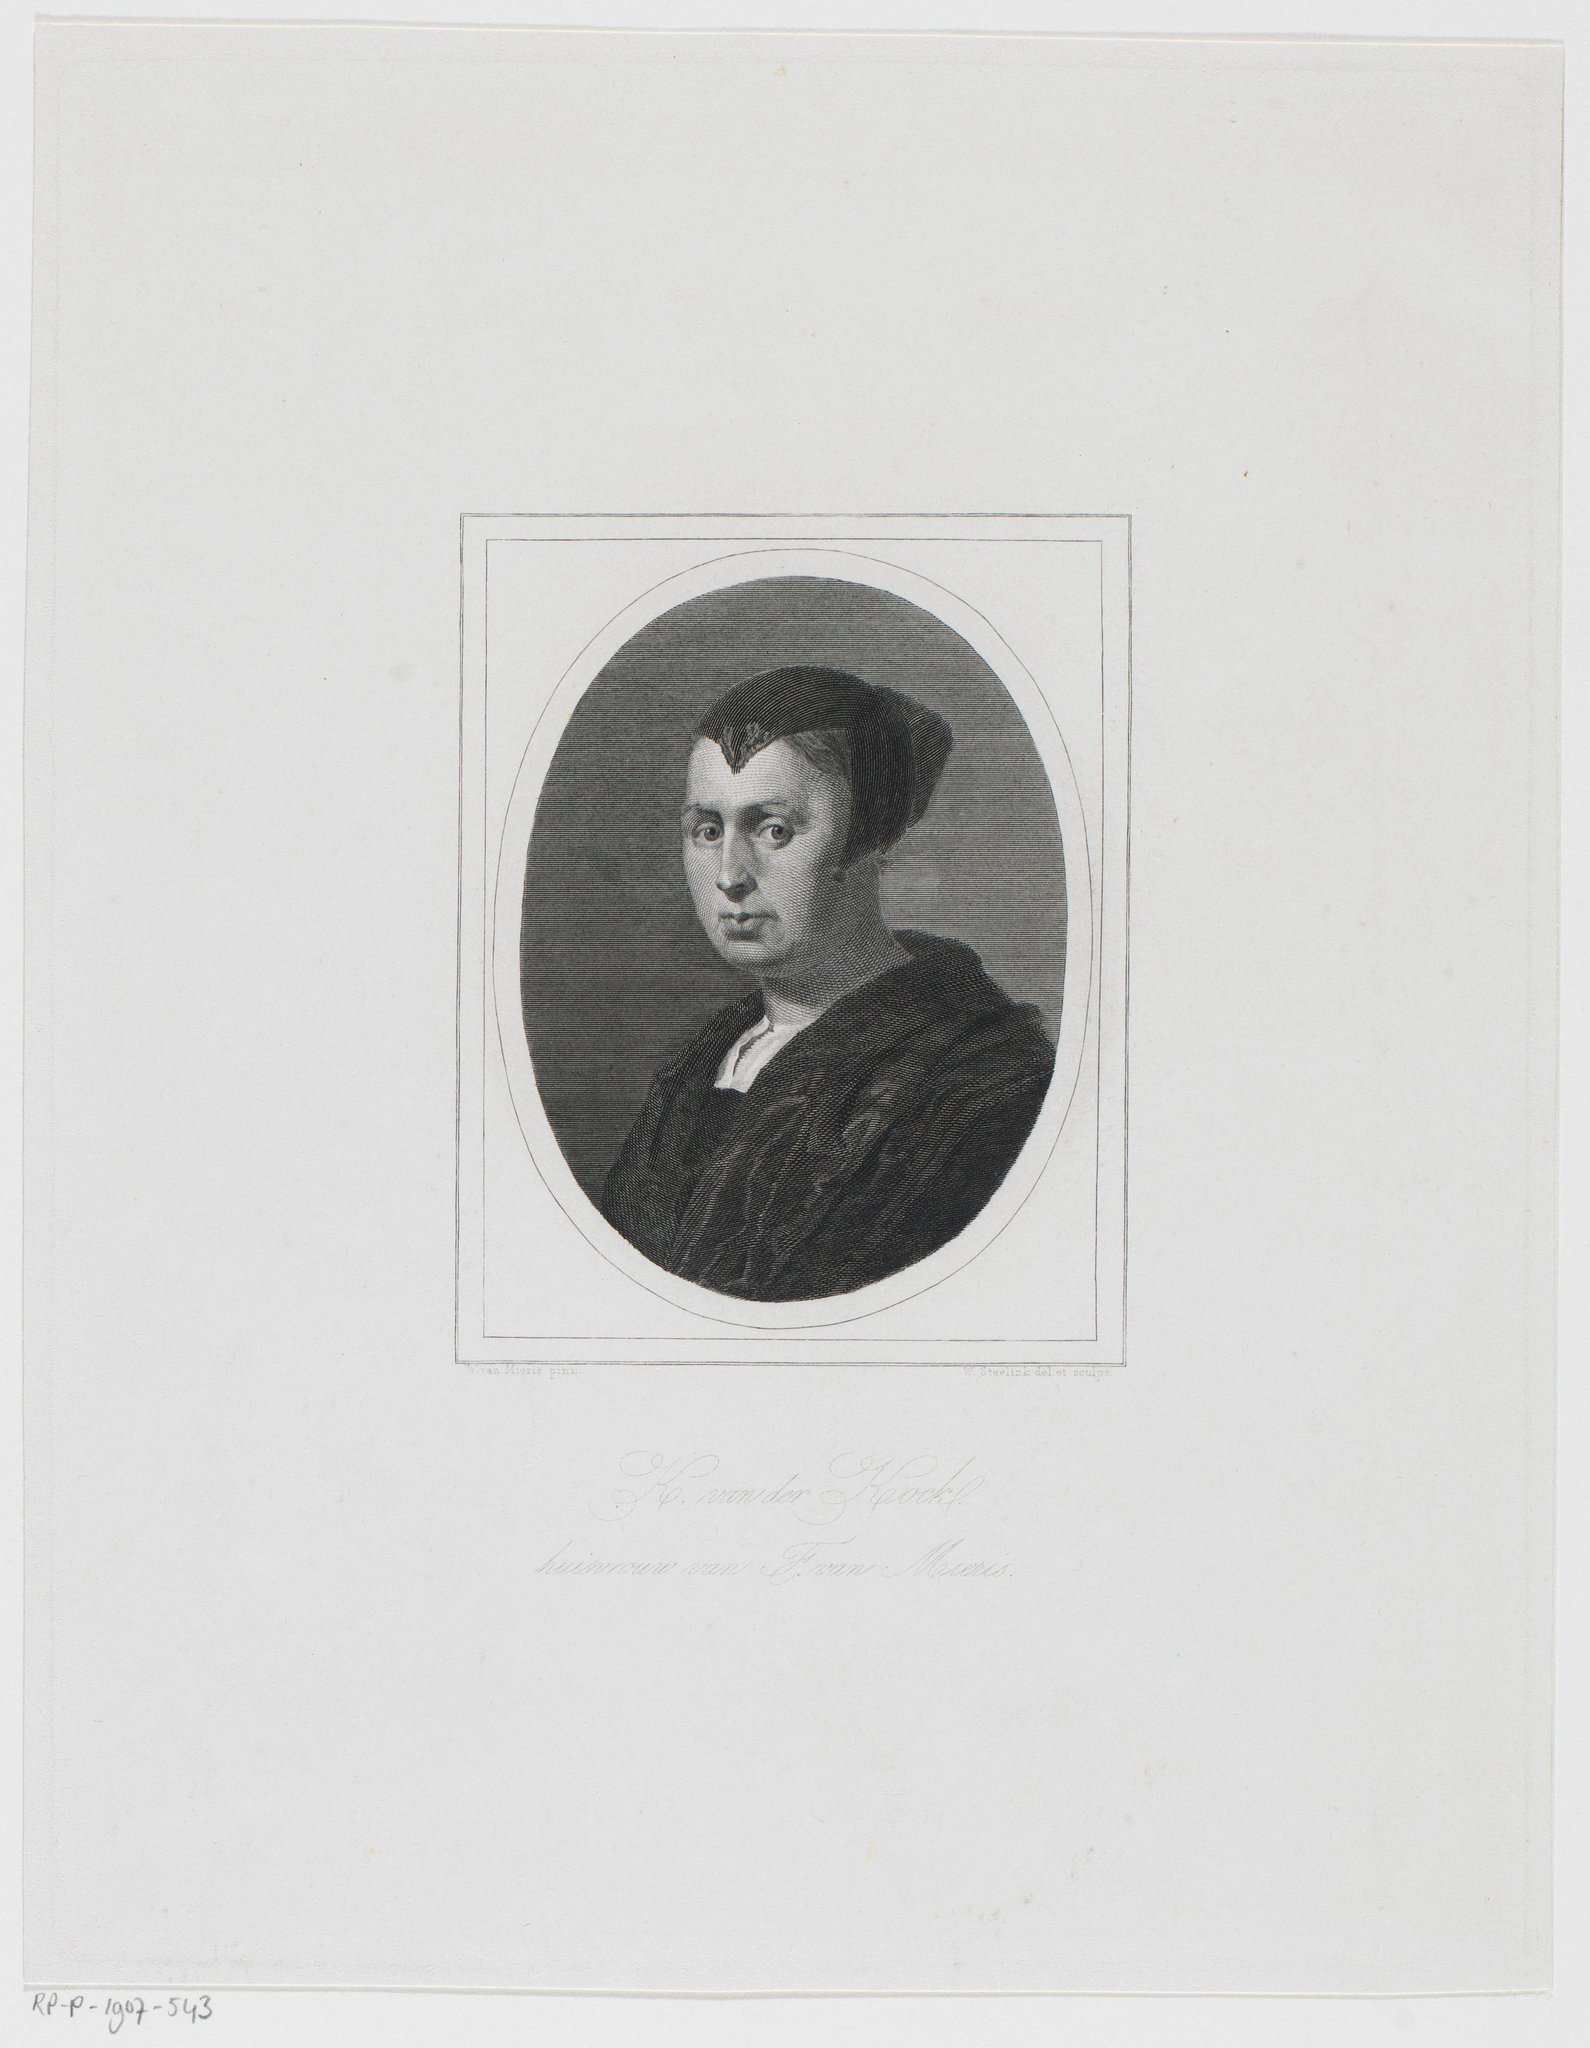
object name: print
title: Portret van Cunera van der Cock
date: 1836-1907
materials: paper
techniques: engraving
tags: cunera van der cock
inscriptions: collector's mark: Lugt 2228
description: Portret van Cunera van der Cock, echtgenote van schilder Frans van Mieris (I).